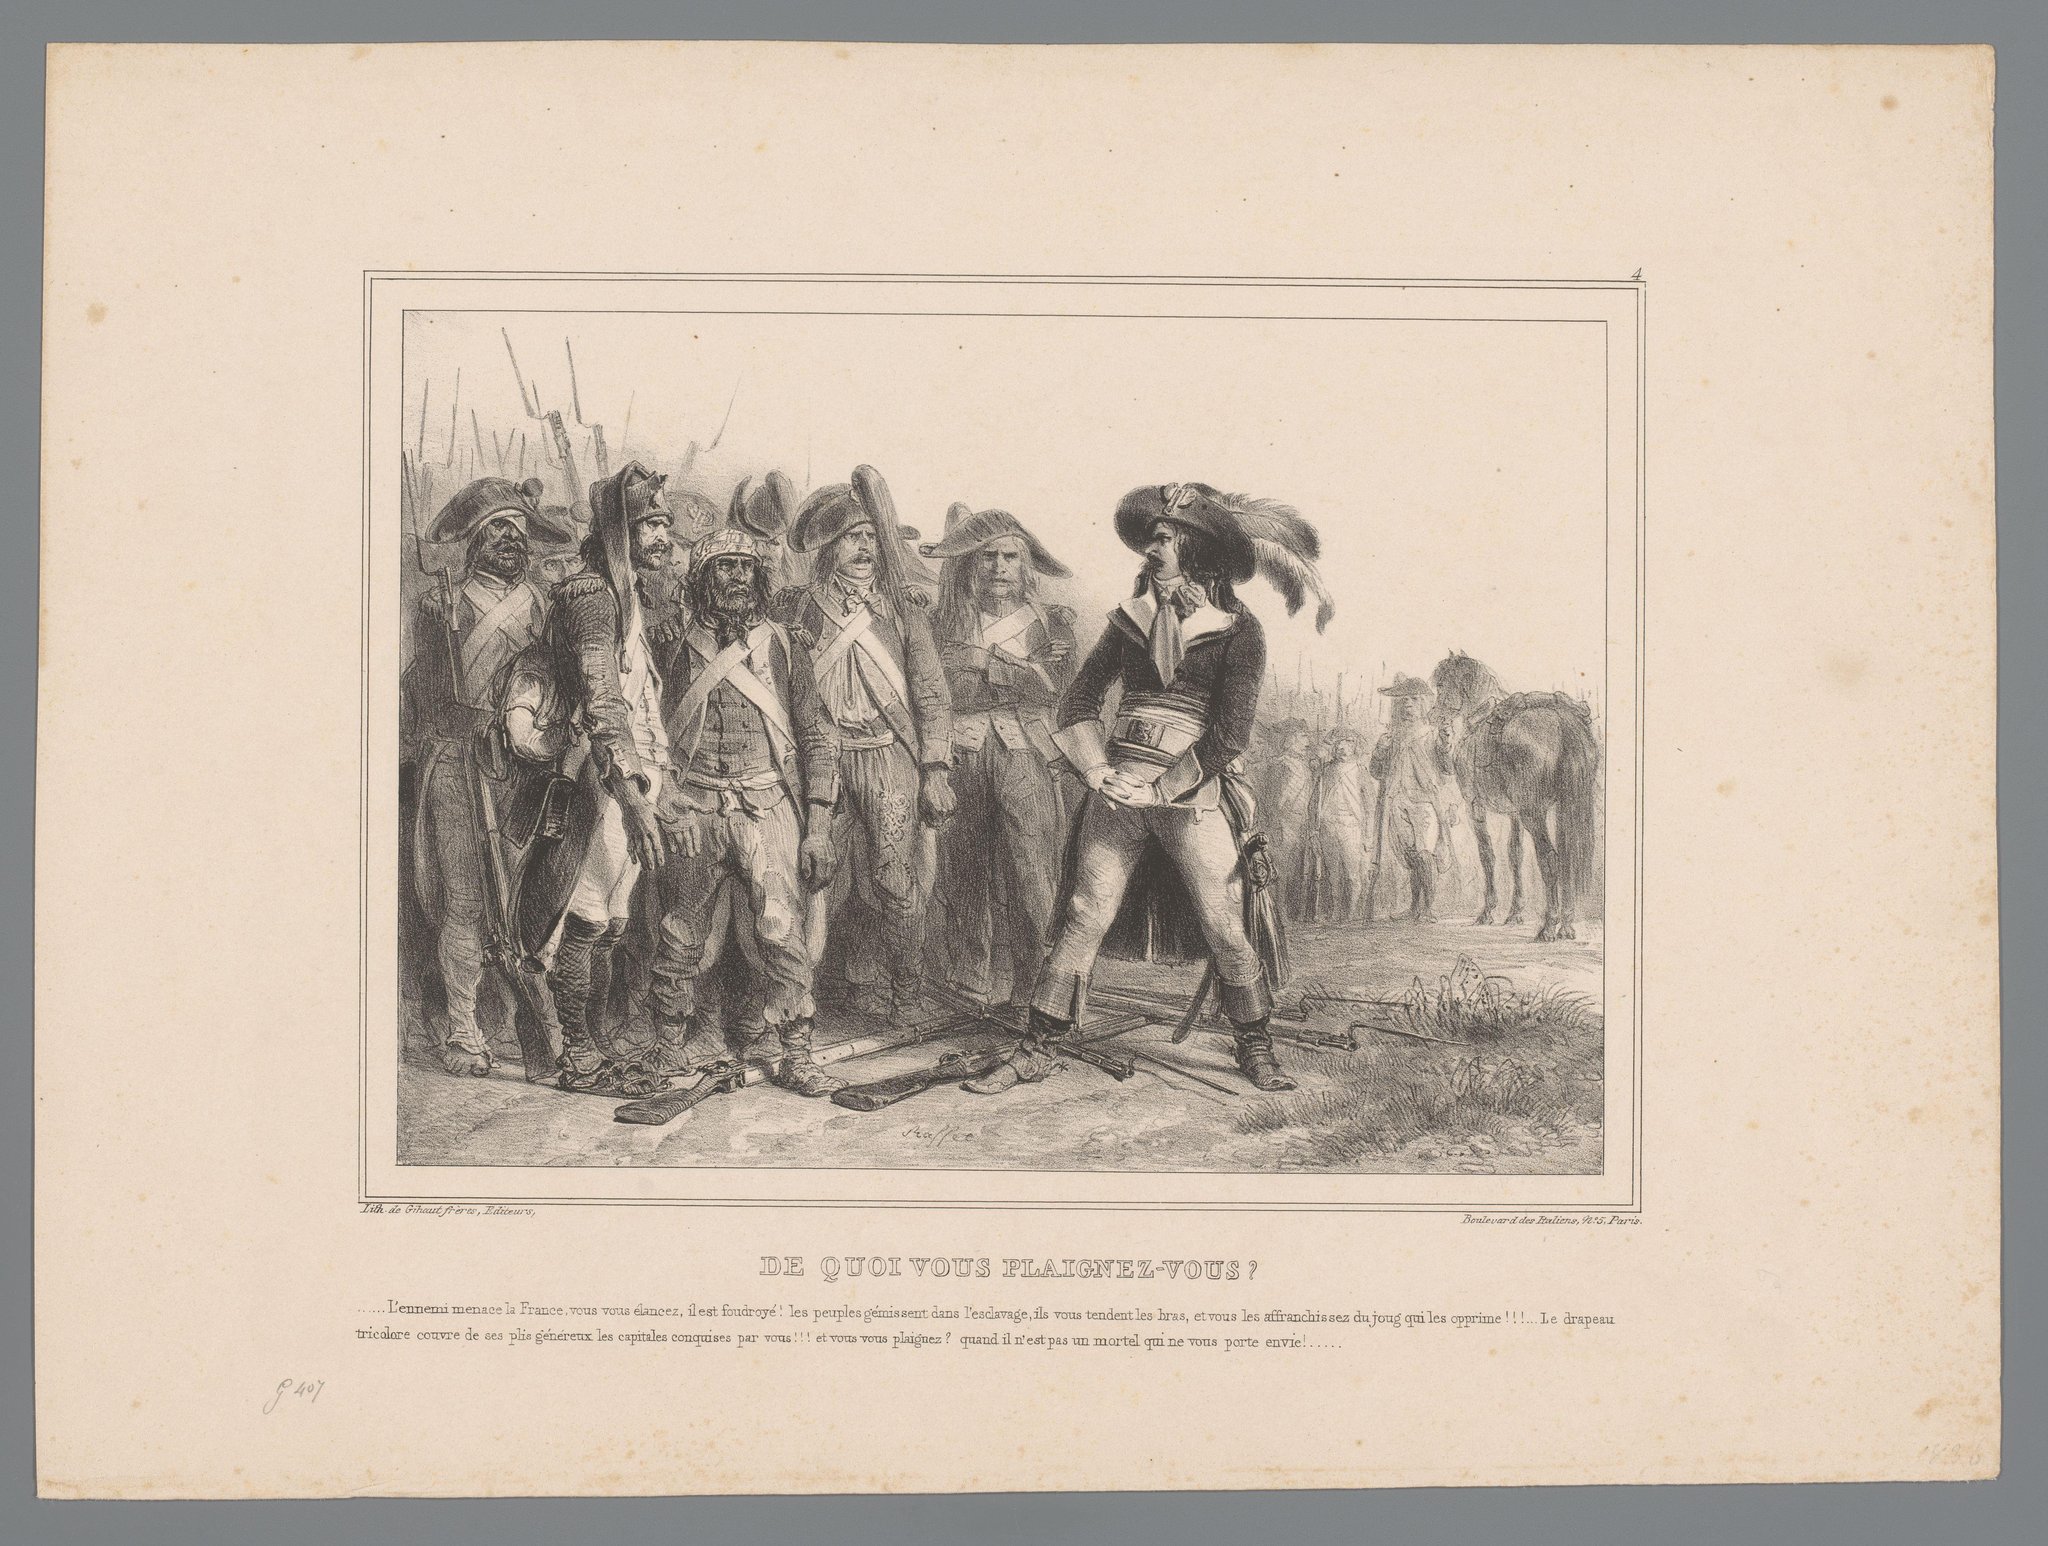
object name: print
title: De quoi vous plaignez-vous?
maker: denis auguste marie raffet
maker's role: draughtsman, print maker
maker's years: 1804-1860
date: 1836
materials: paper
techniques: lithograph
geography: paris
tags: firearms: rifle, the soldier; the soldier's life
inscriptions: collector's mark: Lugt 964